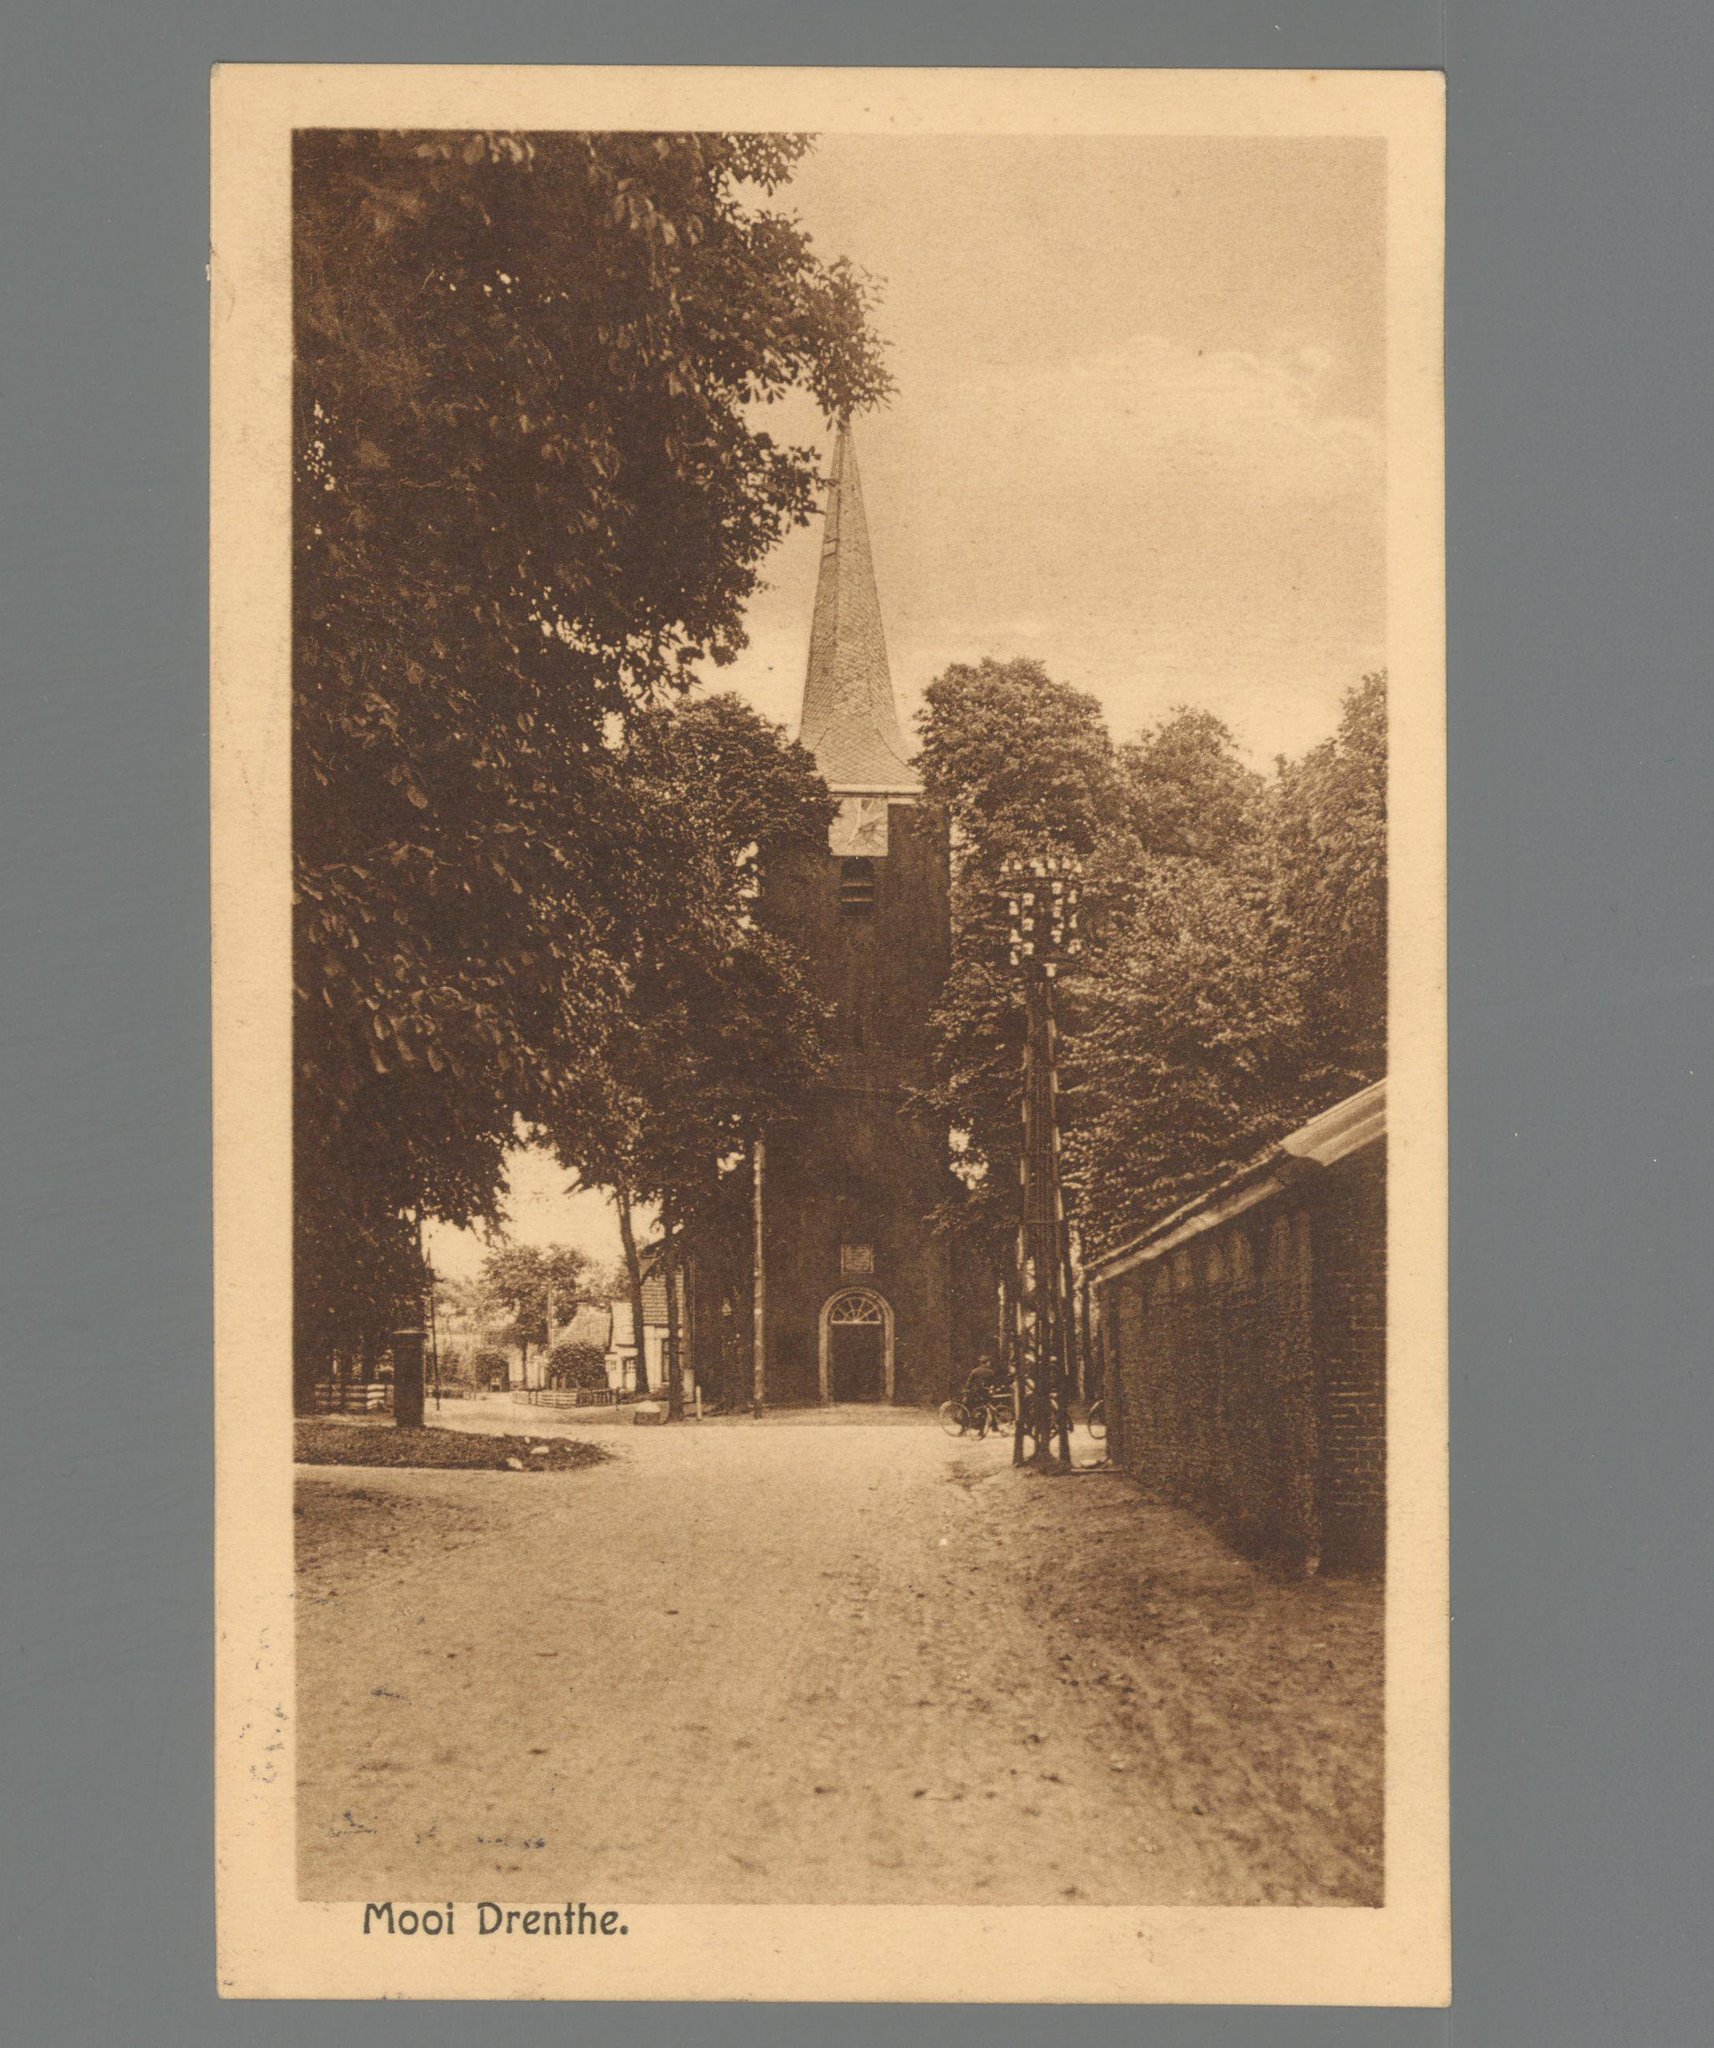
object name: photomechanical print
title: In Gieten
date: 1913-1927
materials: cardboard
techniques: photograph, writing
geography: wildervank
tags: church (exterior)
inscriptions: postage stamp